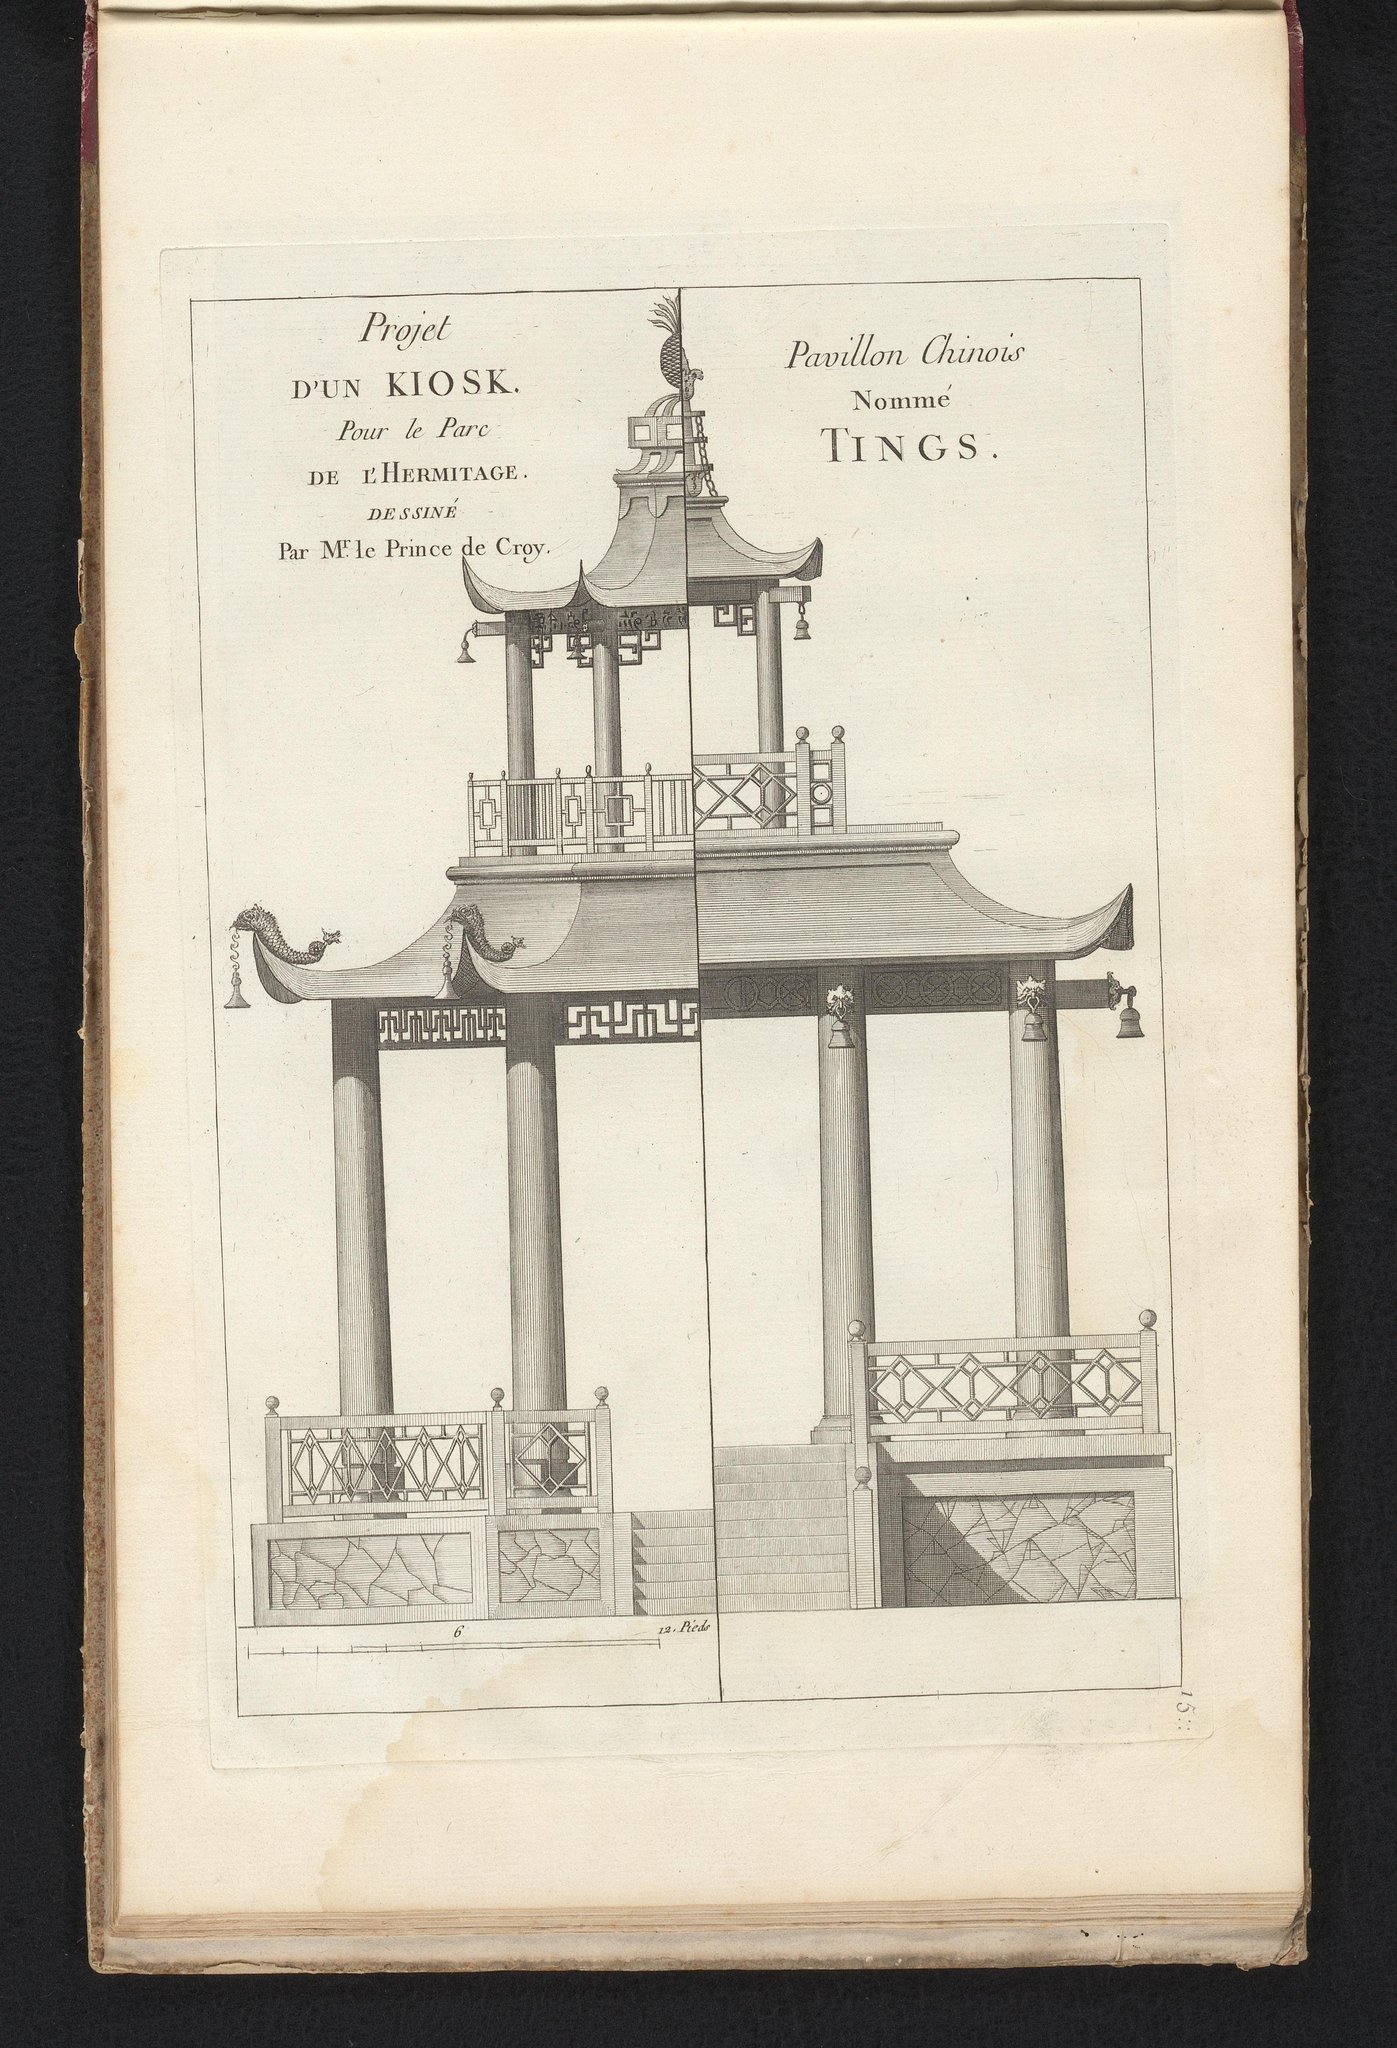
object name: album leaf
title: Twee ontwerpen voor een kiosk in Chinese stijl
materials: paper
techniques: engraving, etching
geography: paris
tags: garden buildings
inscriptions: collector's mark: Lugt 2228, collector's mark: Lugt 2760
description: De serie 'Jardins anglo-chinois à la mode' verscheen in totaal in 21 zogeheten 'cahiers' (afleveringen). De huidige prent komt uit het vierde 'cahier'. Het Rijksmuseum Amsterdam bezit drie banden met daarin in totaal zes 'cahiers' van deze reeks. In de documentatie wordt verwezen naar een in de bibliotheek van het Rijksmuseum Amsterdam aanwezige facsimile van het complete werk.